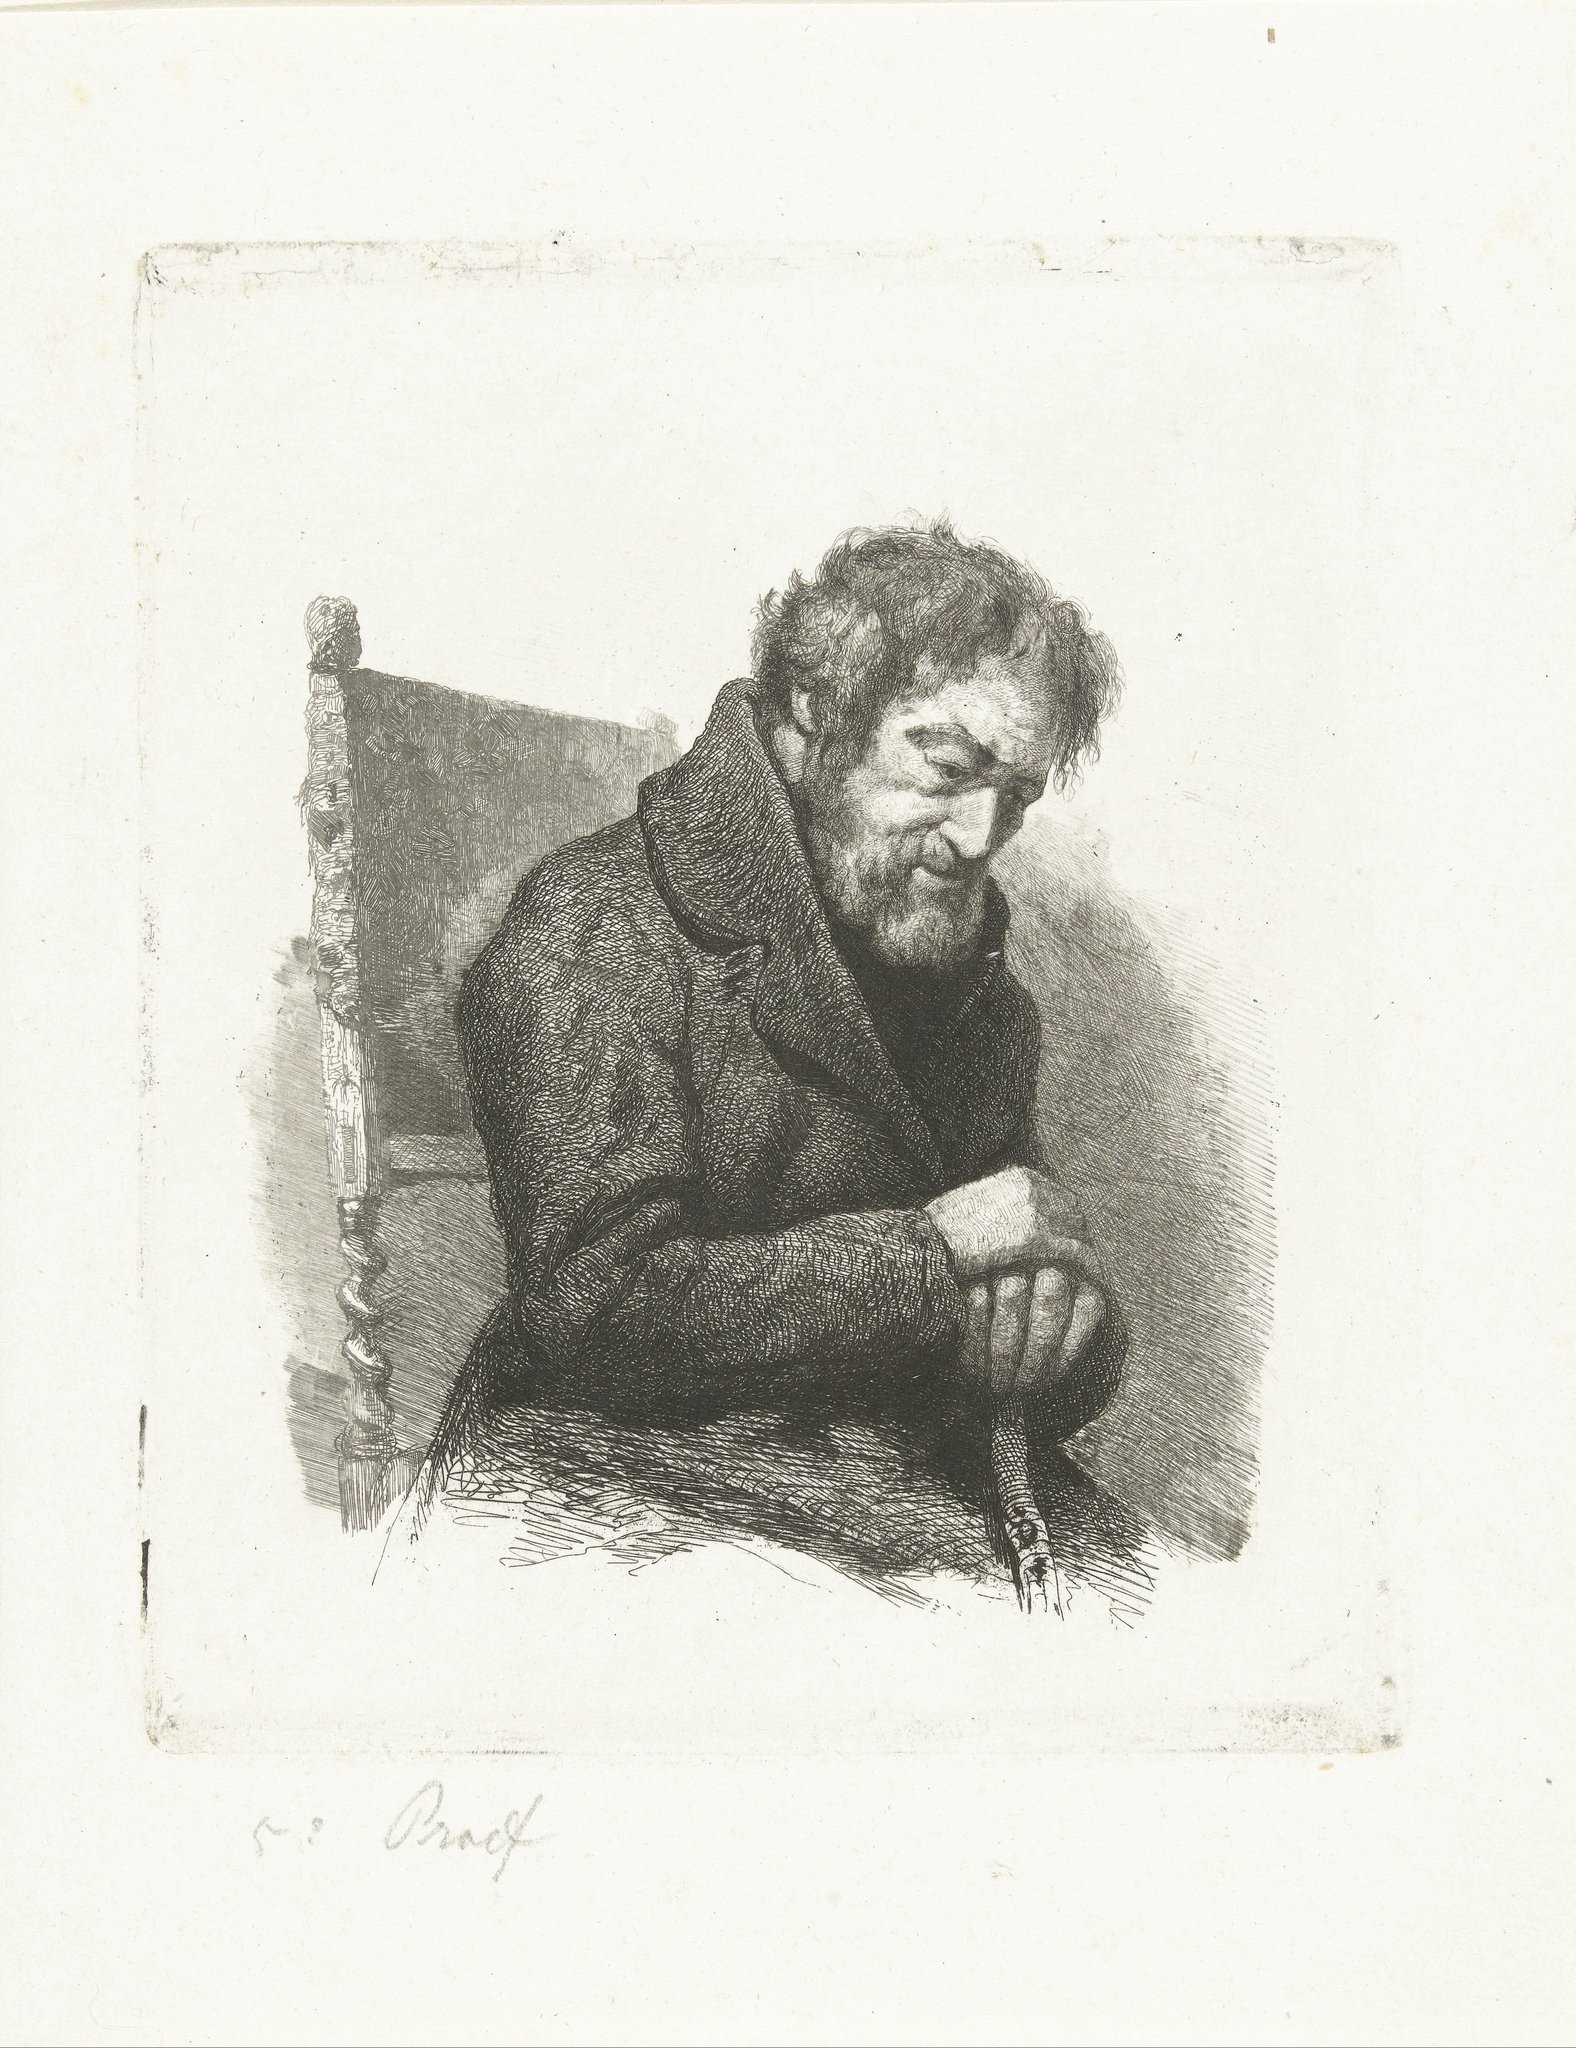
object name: print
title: Zittende grijsaard met wandelstok in zijn handen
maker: pierre louis dubourcq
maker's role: draughtsman, painter, print maker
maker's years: 1815-1873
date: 1845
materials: paper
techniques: etching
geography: netherlands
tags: old man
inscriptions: collector's mark: Lugt 2228